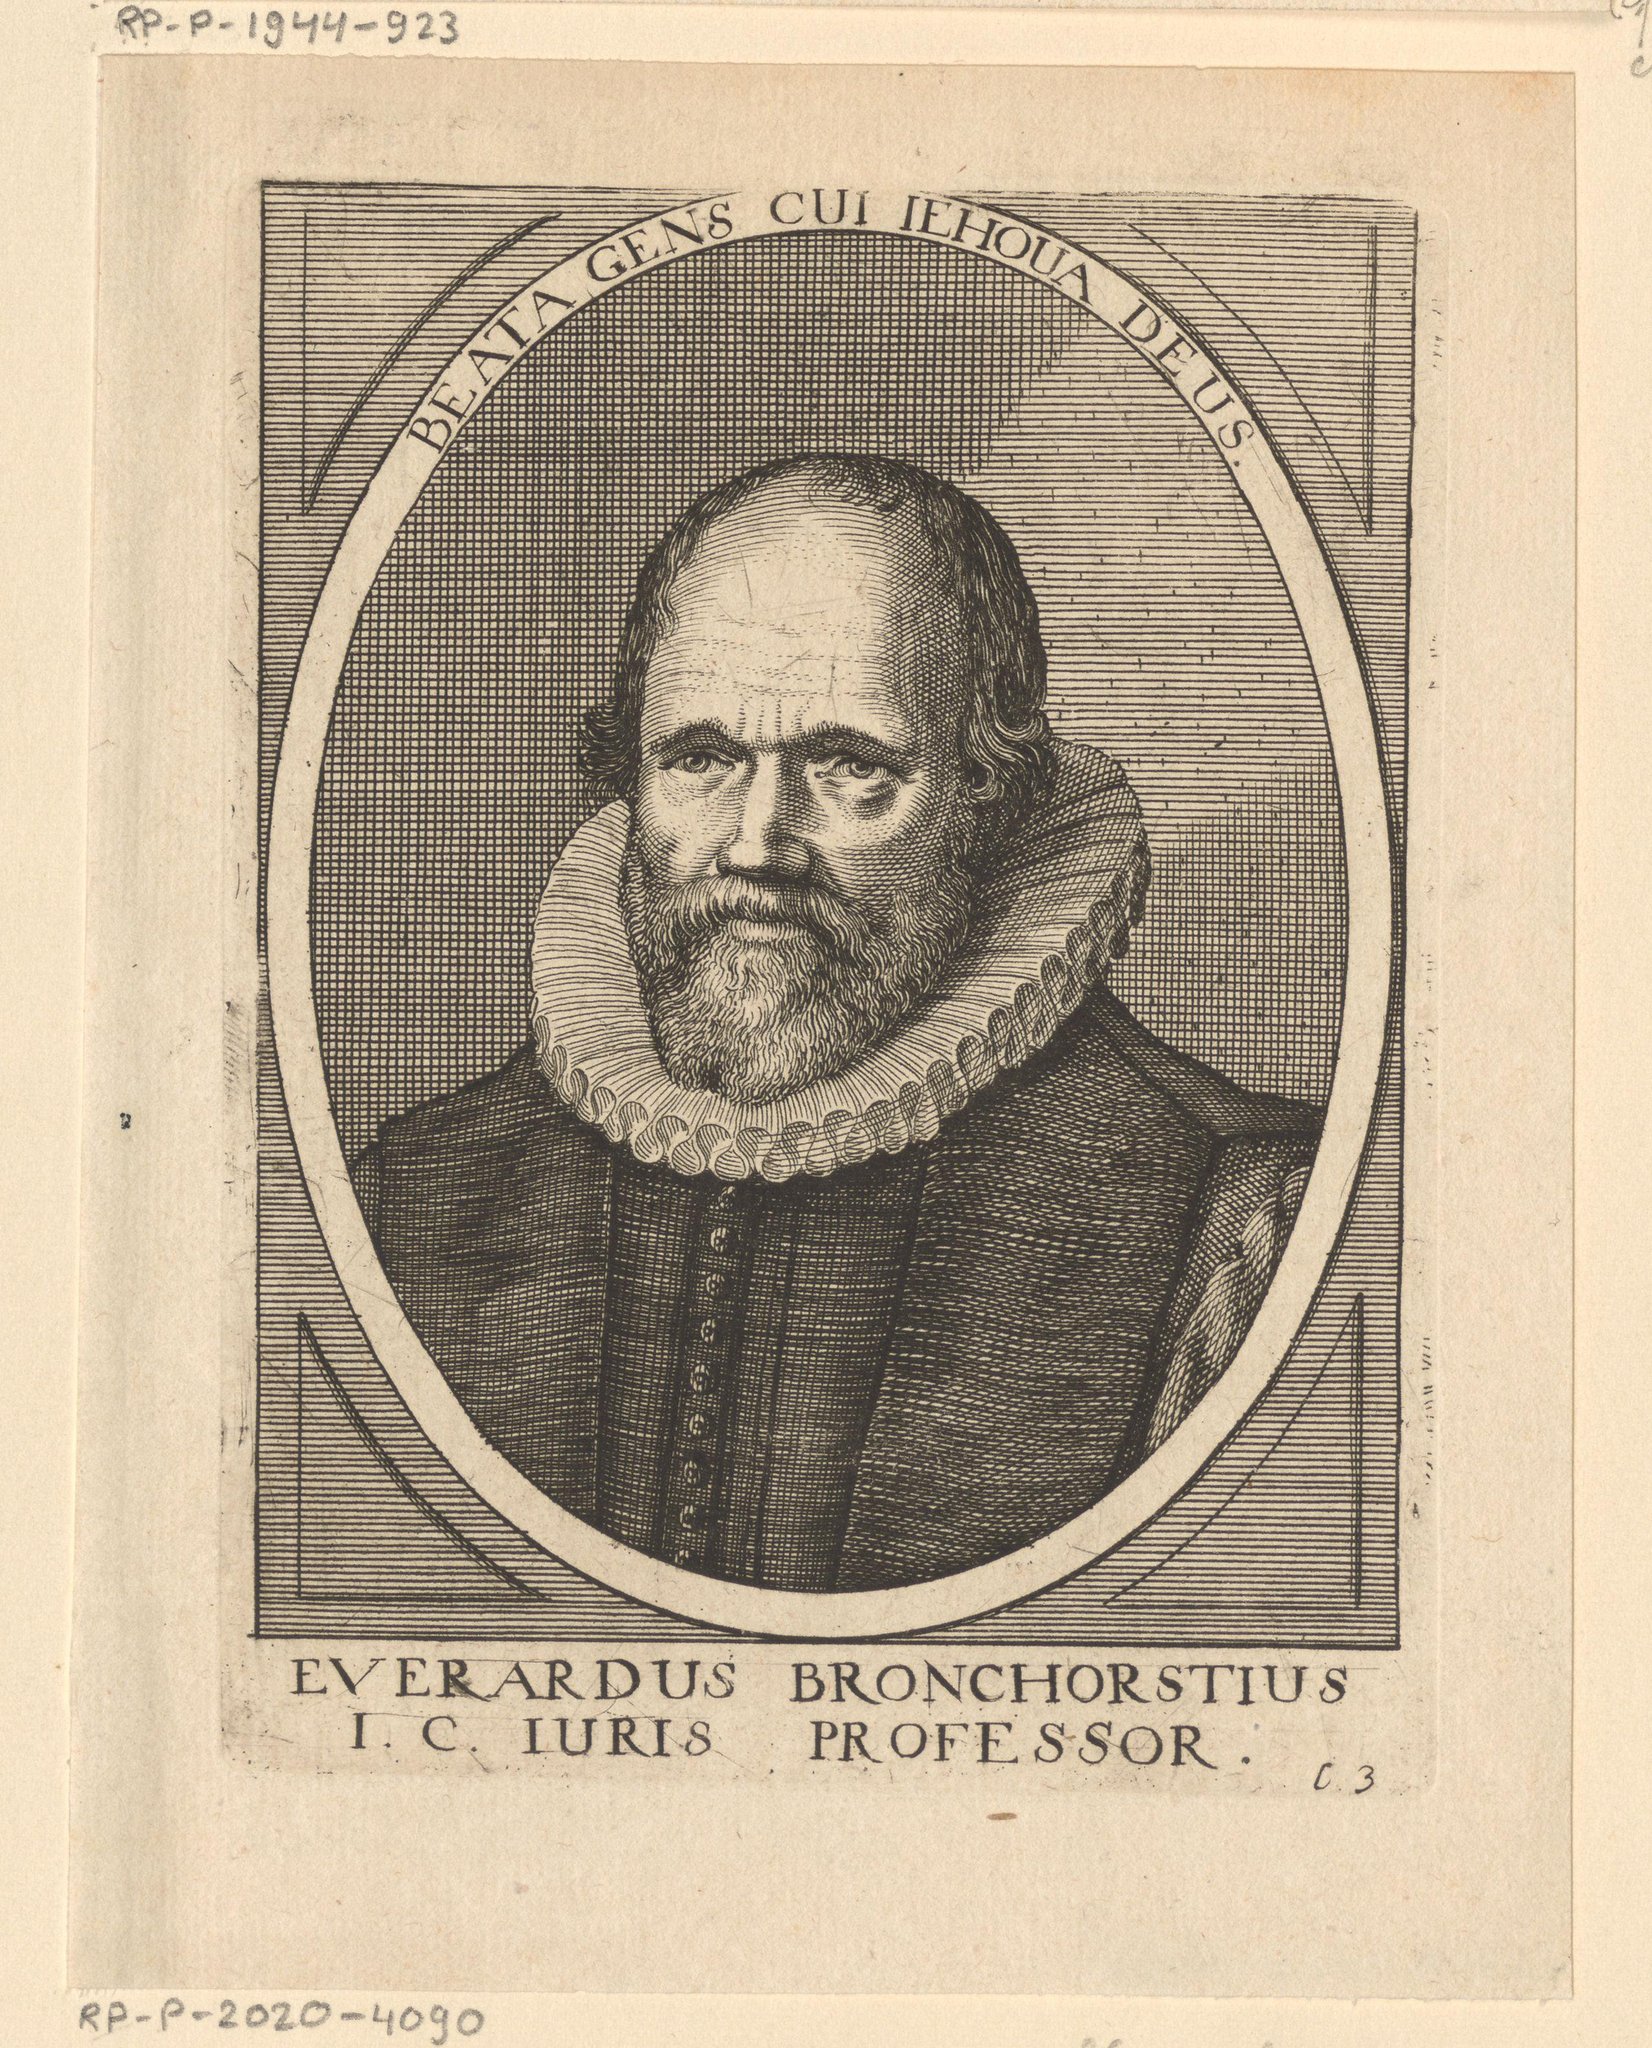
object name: print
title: Portret van Everard van Bronkhorst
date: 1650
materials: paper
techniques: engraving, etching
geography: frankfurt am main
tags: deventer, leiden, historical persons, professor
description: Prent uit: Bibliotheca chalcographica. Frankfurt am Main: Johannes Ammon, 1650, dl. 6.